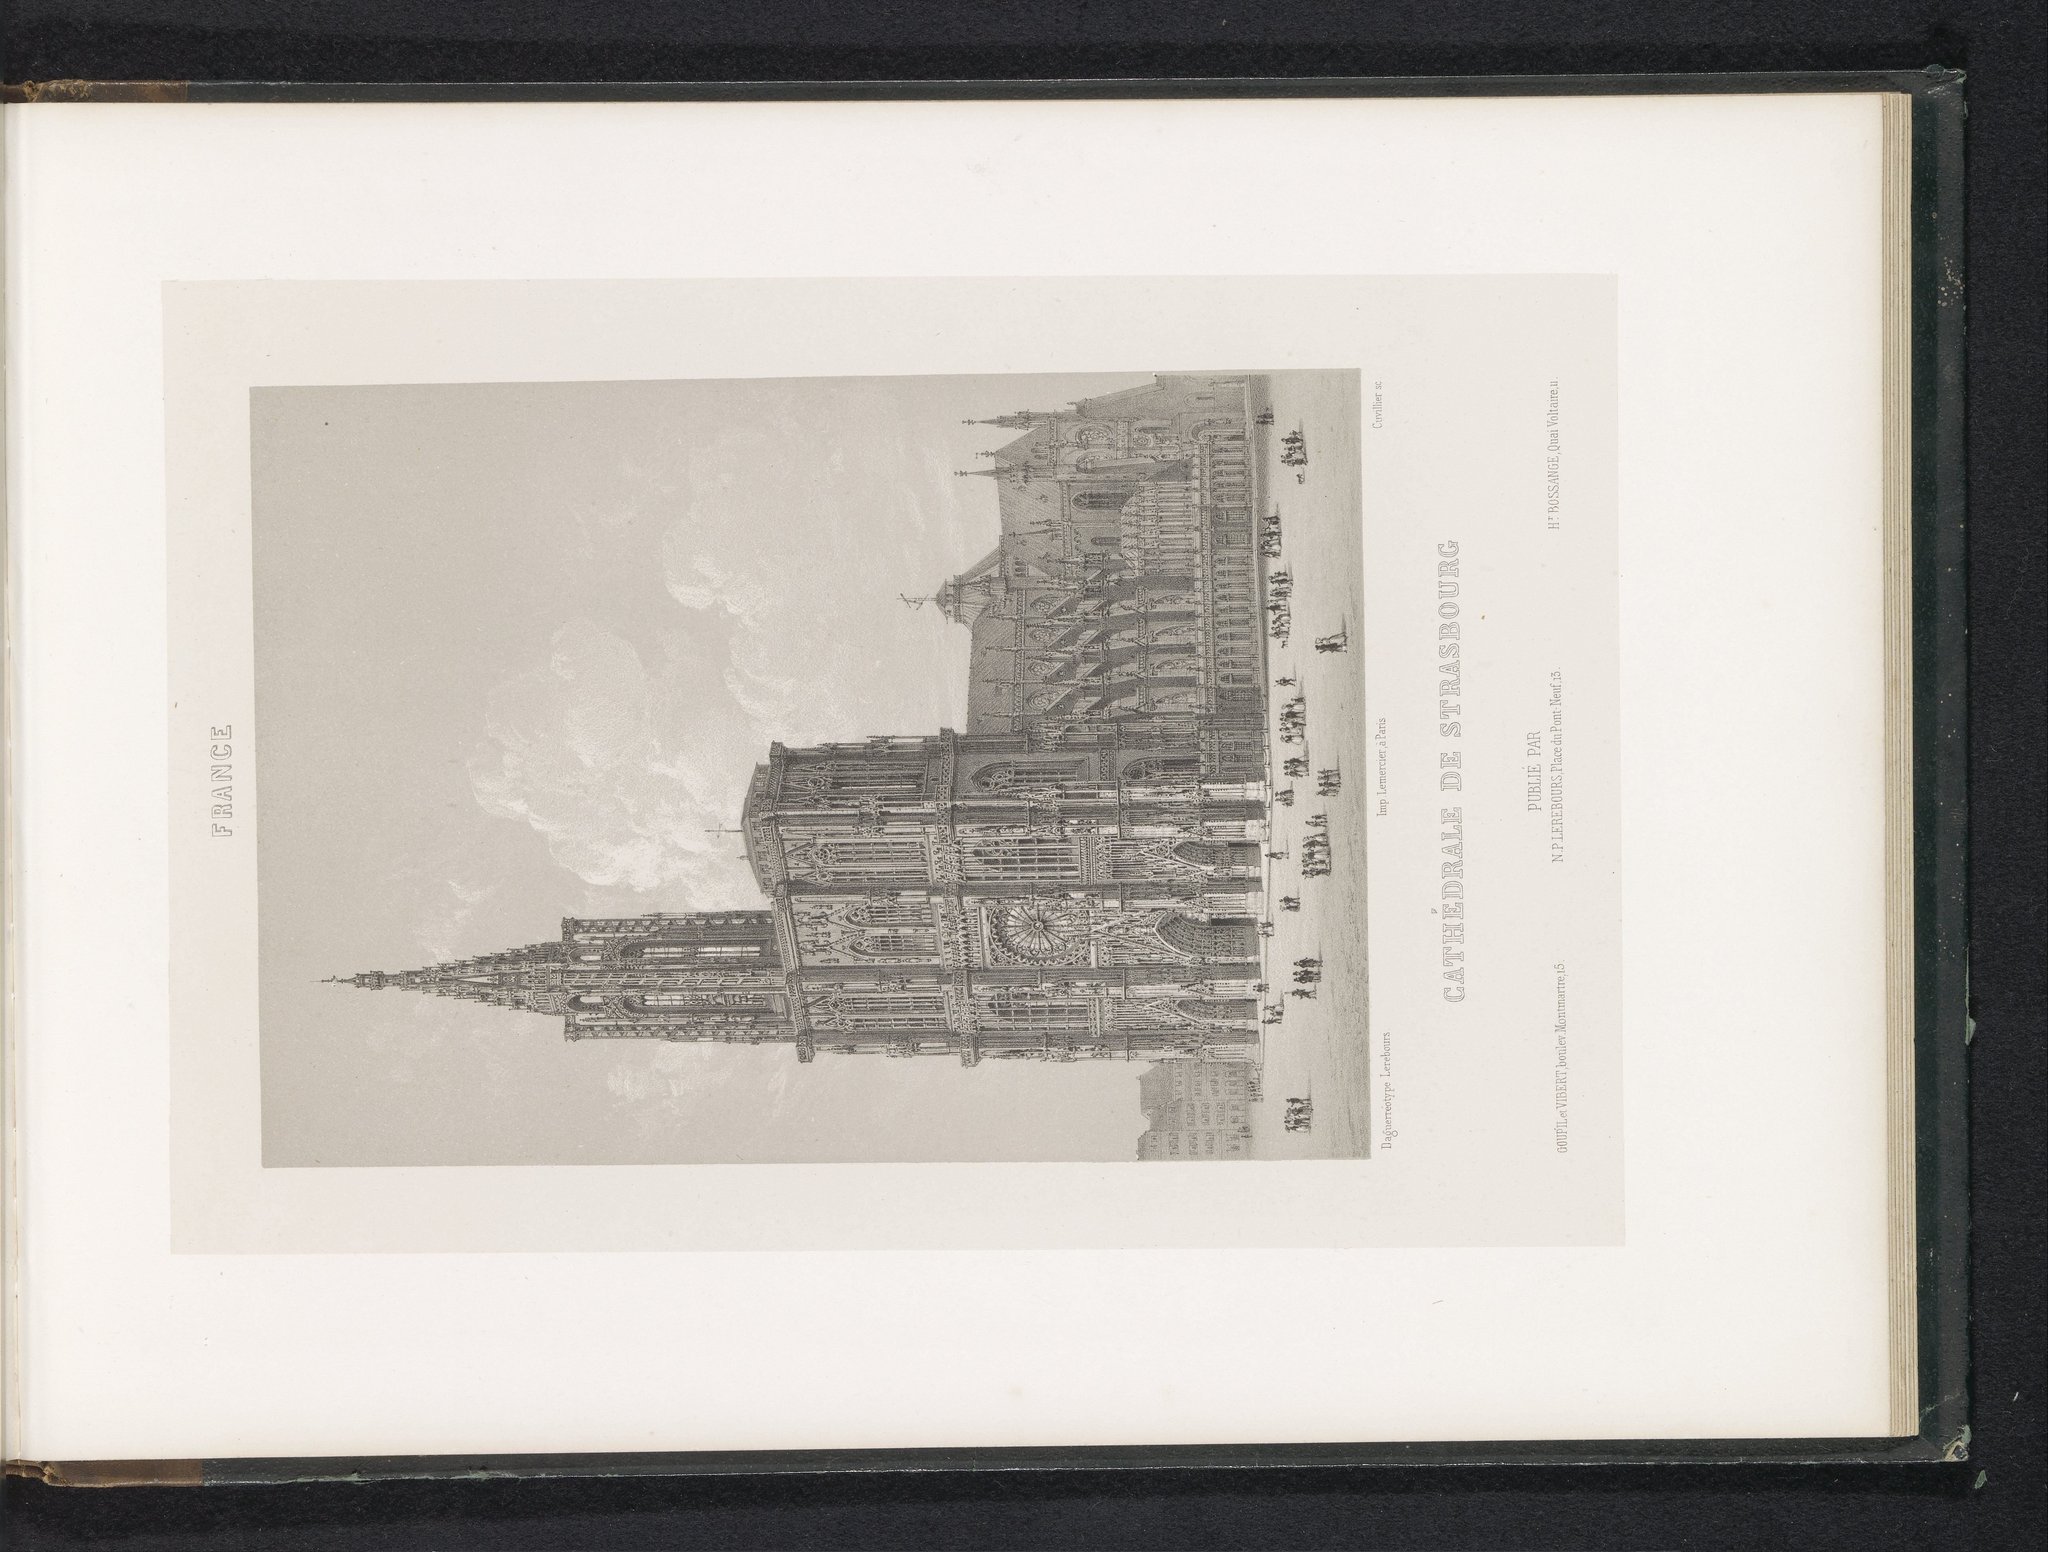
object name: print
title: France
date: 1839-1841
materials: paper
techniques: aquatint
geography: straatsburg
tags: church (exterior), façade (of house or building)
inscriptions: inscription: ‘N.P. Lerebours Place du Pont Neuf 15’, inscription: ‘Hr. Bossance Quai Voltaire 11’, inscription: ‘Rittner & Goupil Boulevd Montmartre 15’